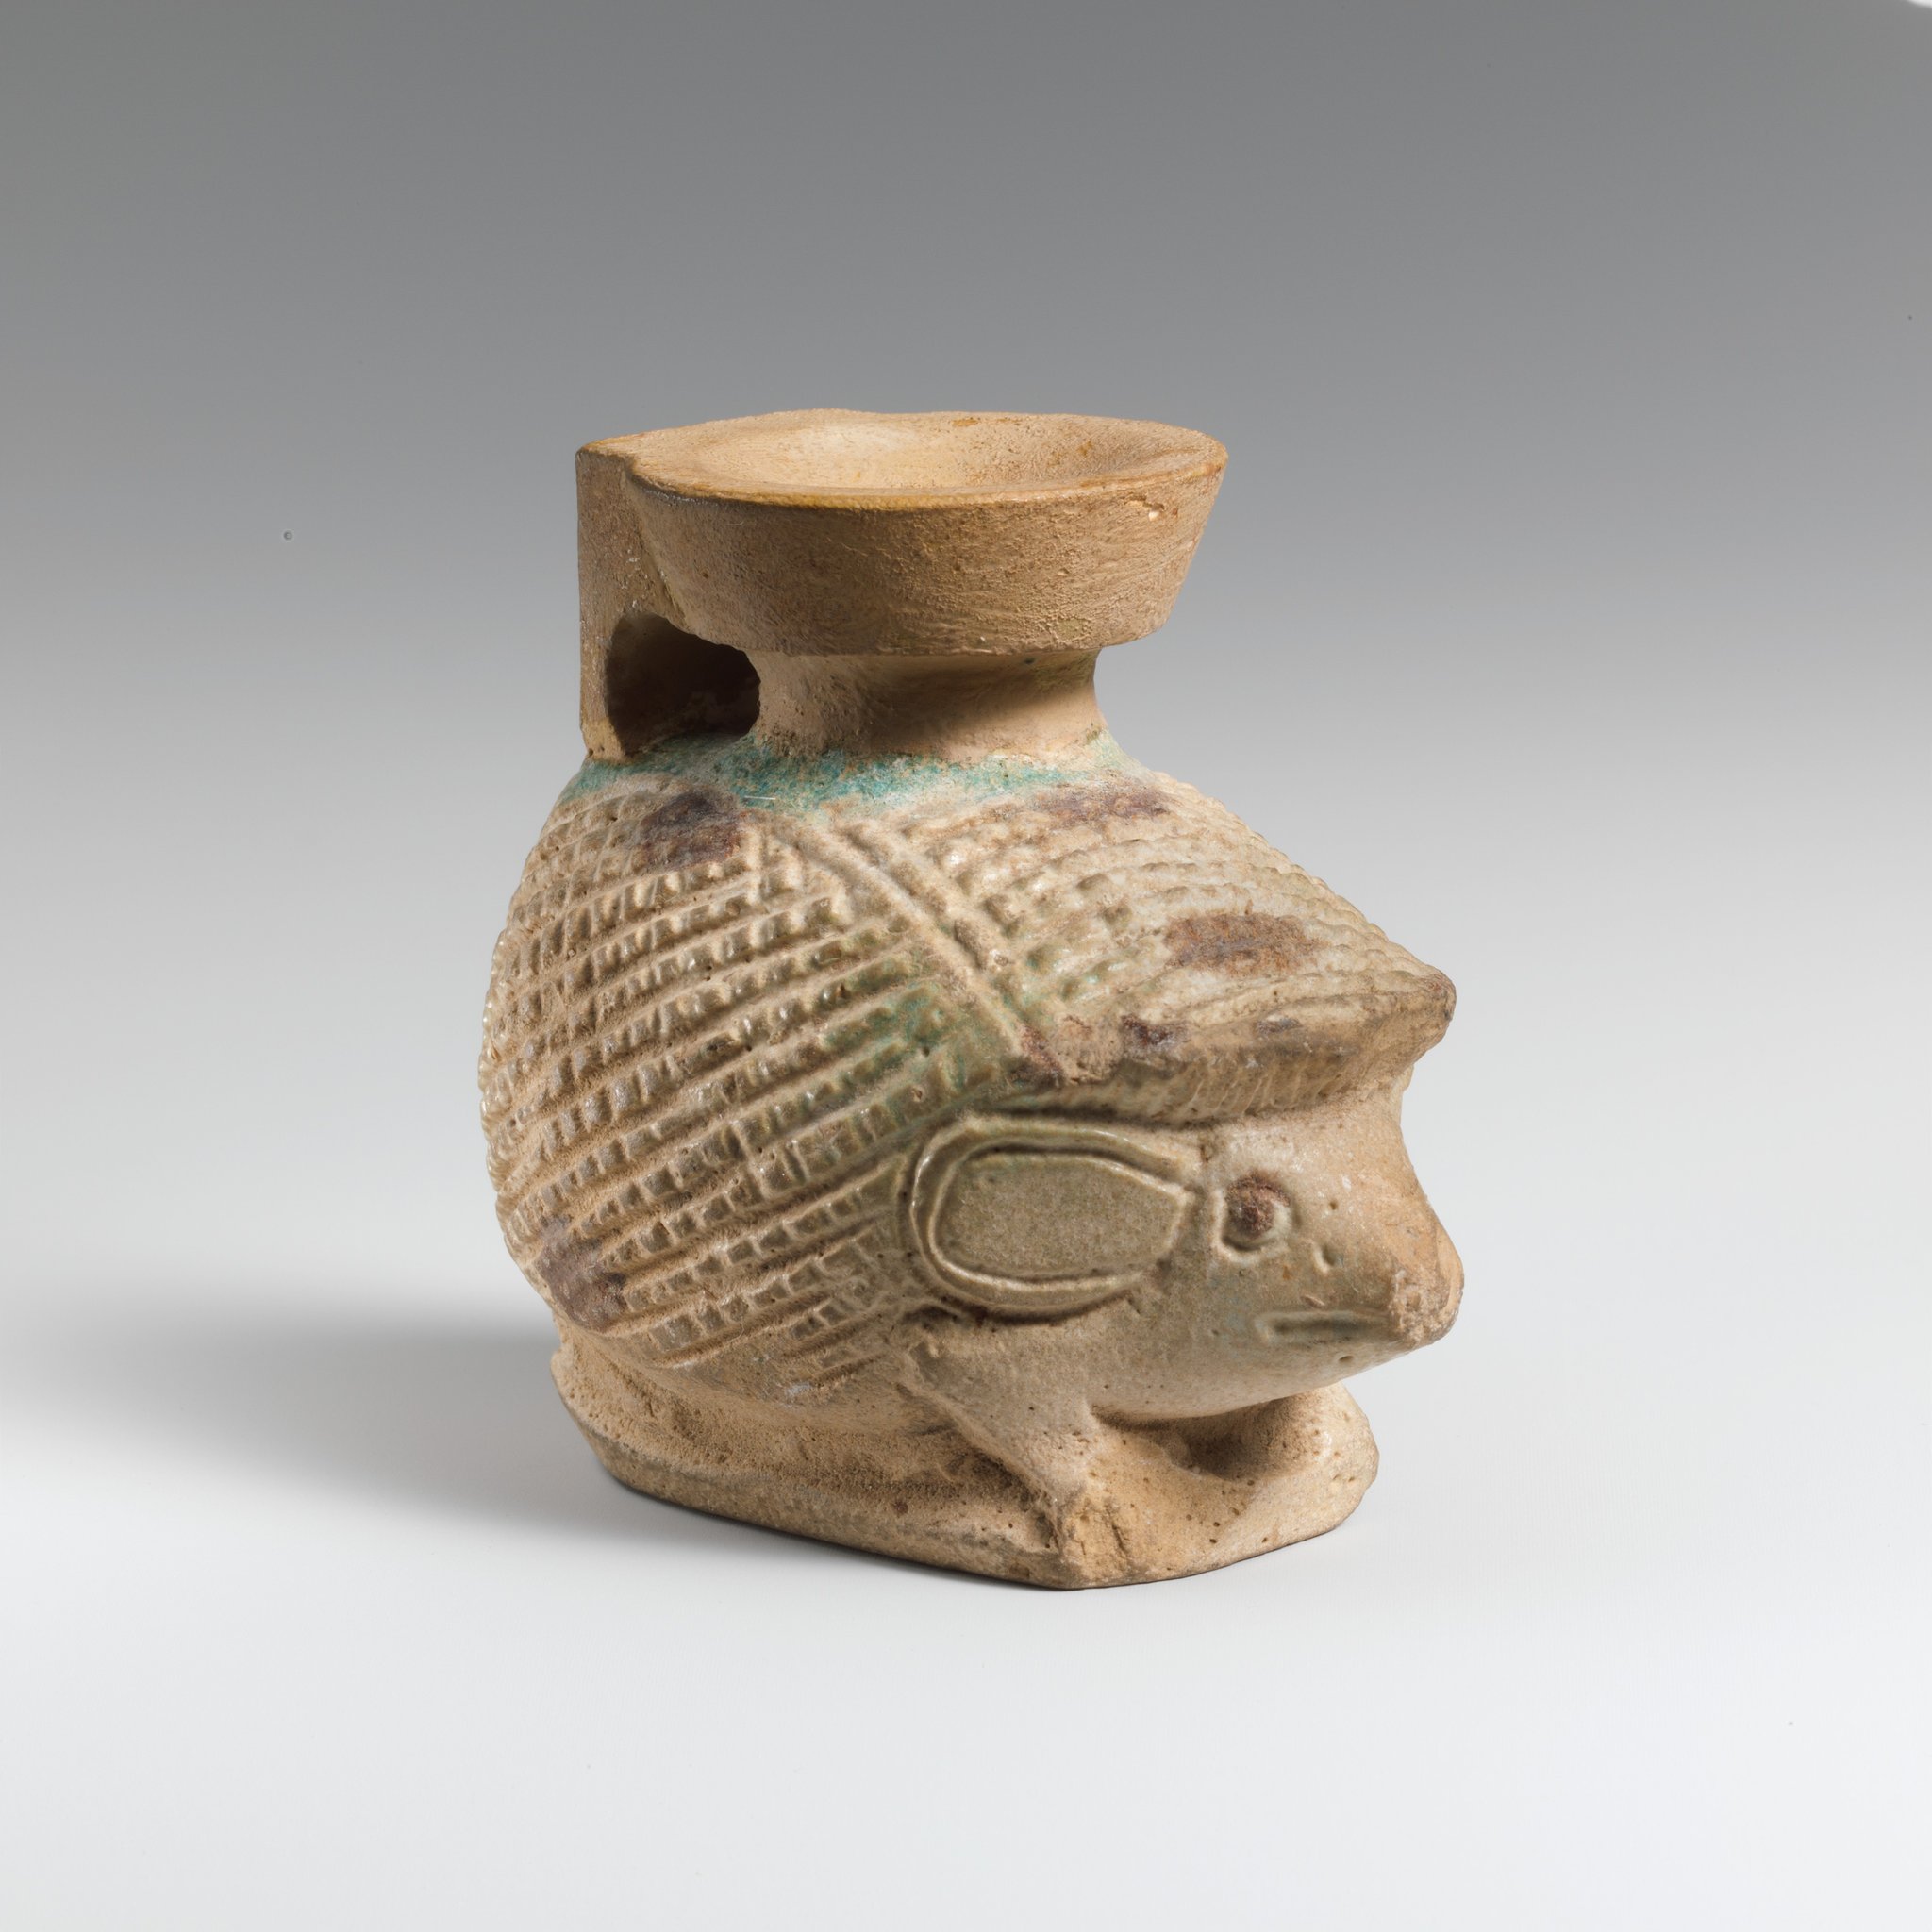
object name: aryballos in the form of a hedgehog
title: Faience aryballos (oil flask) in the form of a hedgehog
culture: east greek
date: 600-501 BCE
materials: faience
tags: hedgehogs